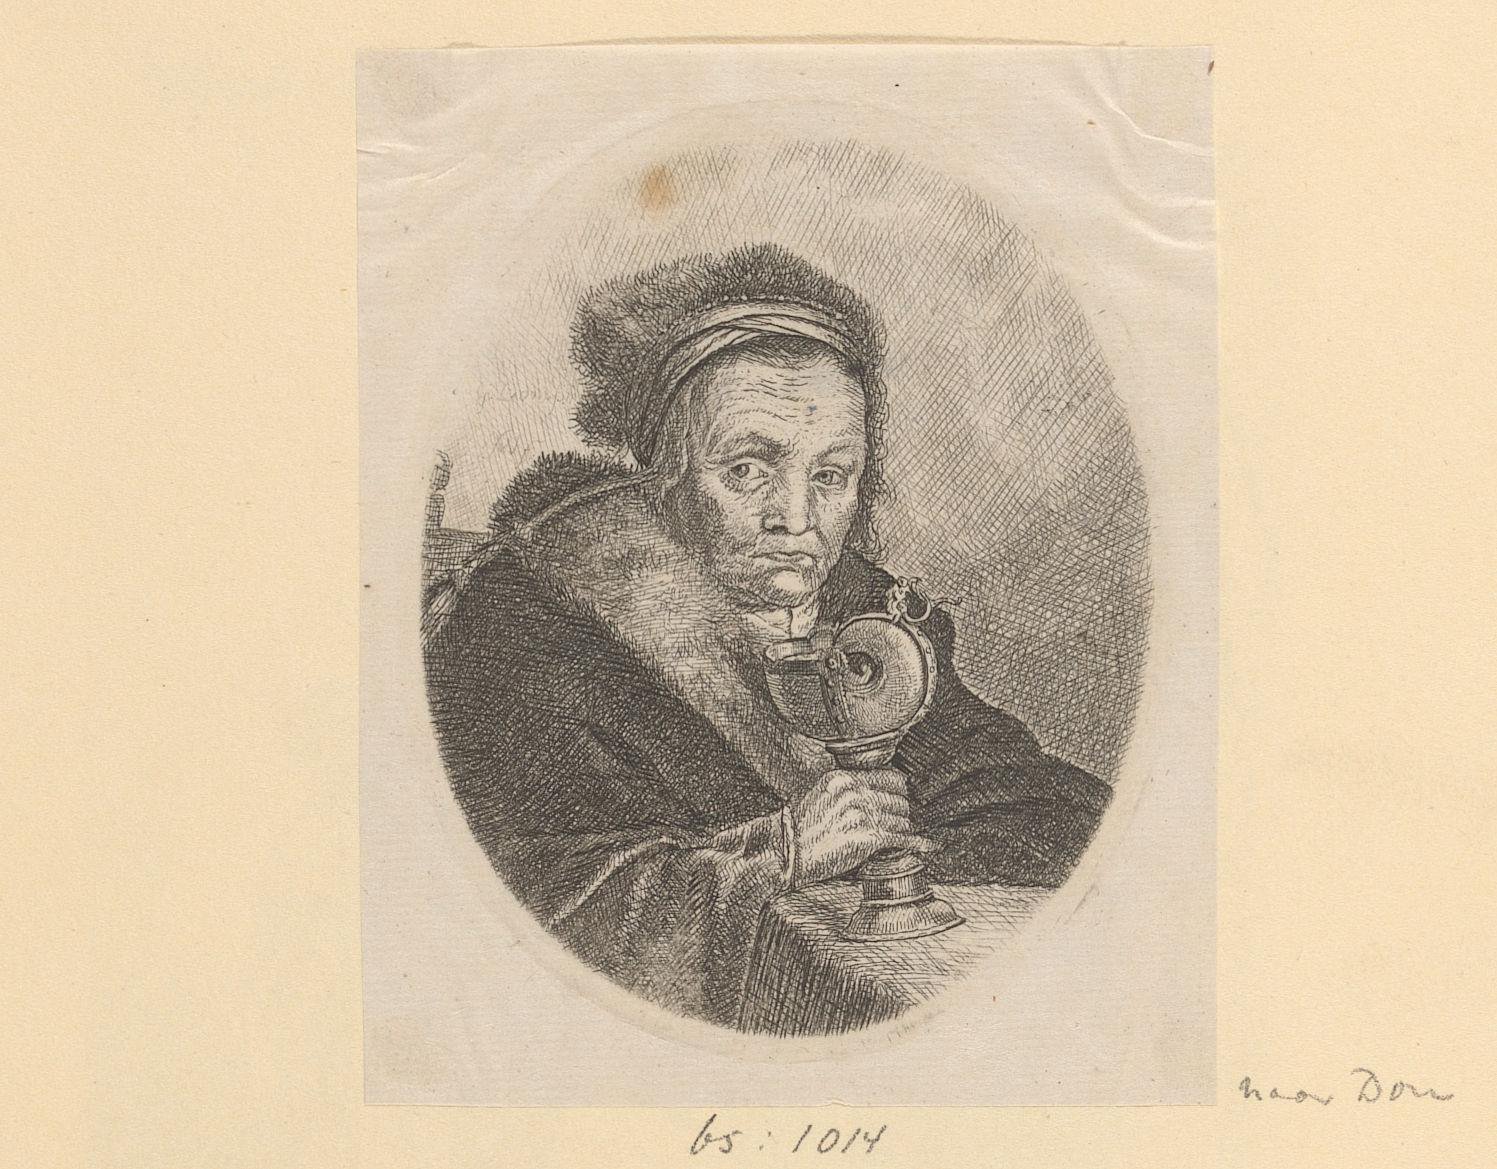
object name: album leaf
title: Oude vrouw met nautilusbeker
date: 1719-1780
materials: paper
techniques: etching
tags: nautilus cup, old woman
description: Prent maakt mogelijk deel uit van een serie van 200 prenten. Deze serie is onder de titel 'A Collection of two hundred original etchings' voor het eerst uitgegeven door J.M. Greery in 1816.